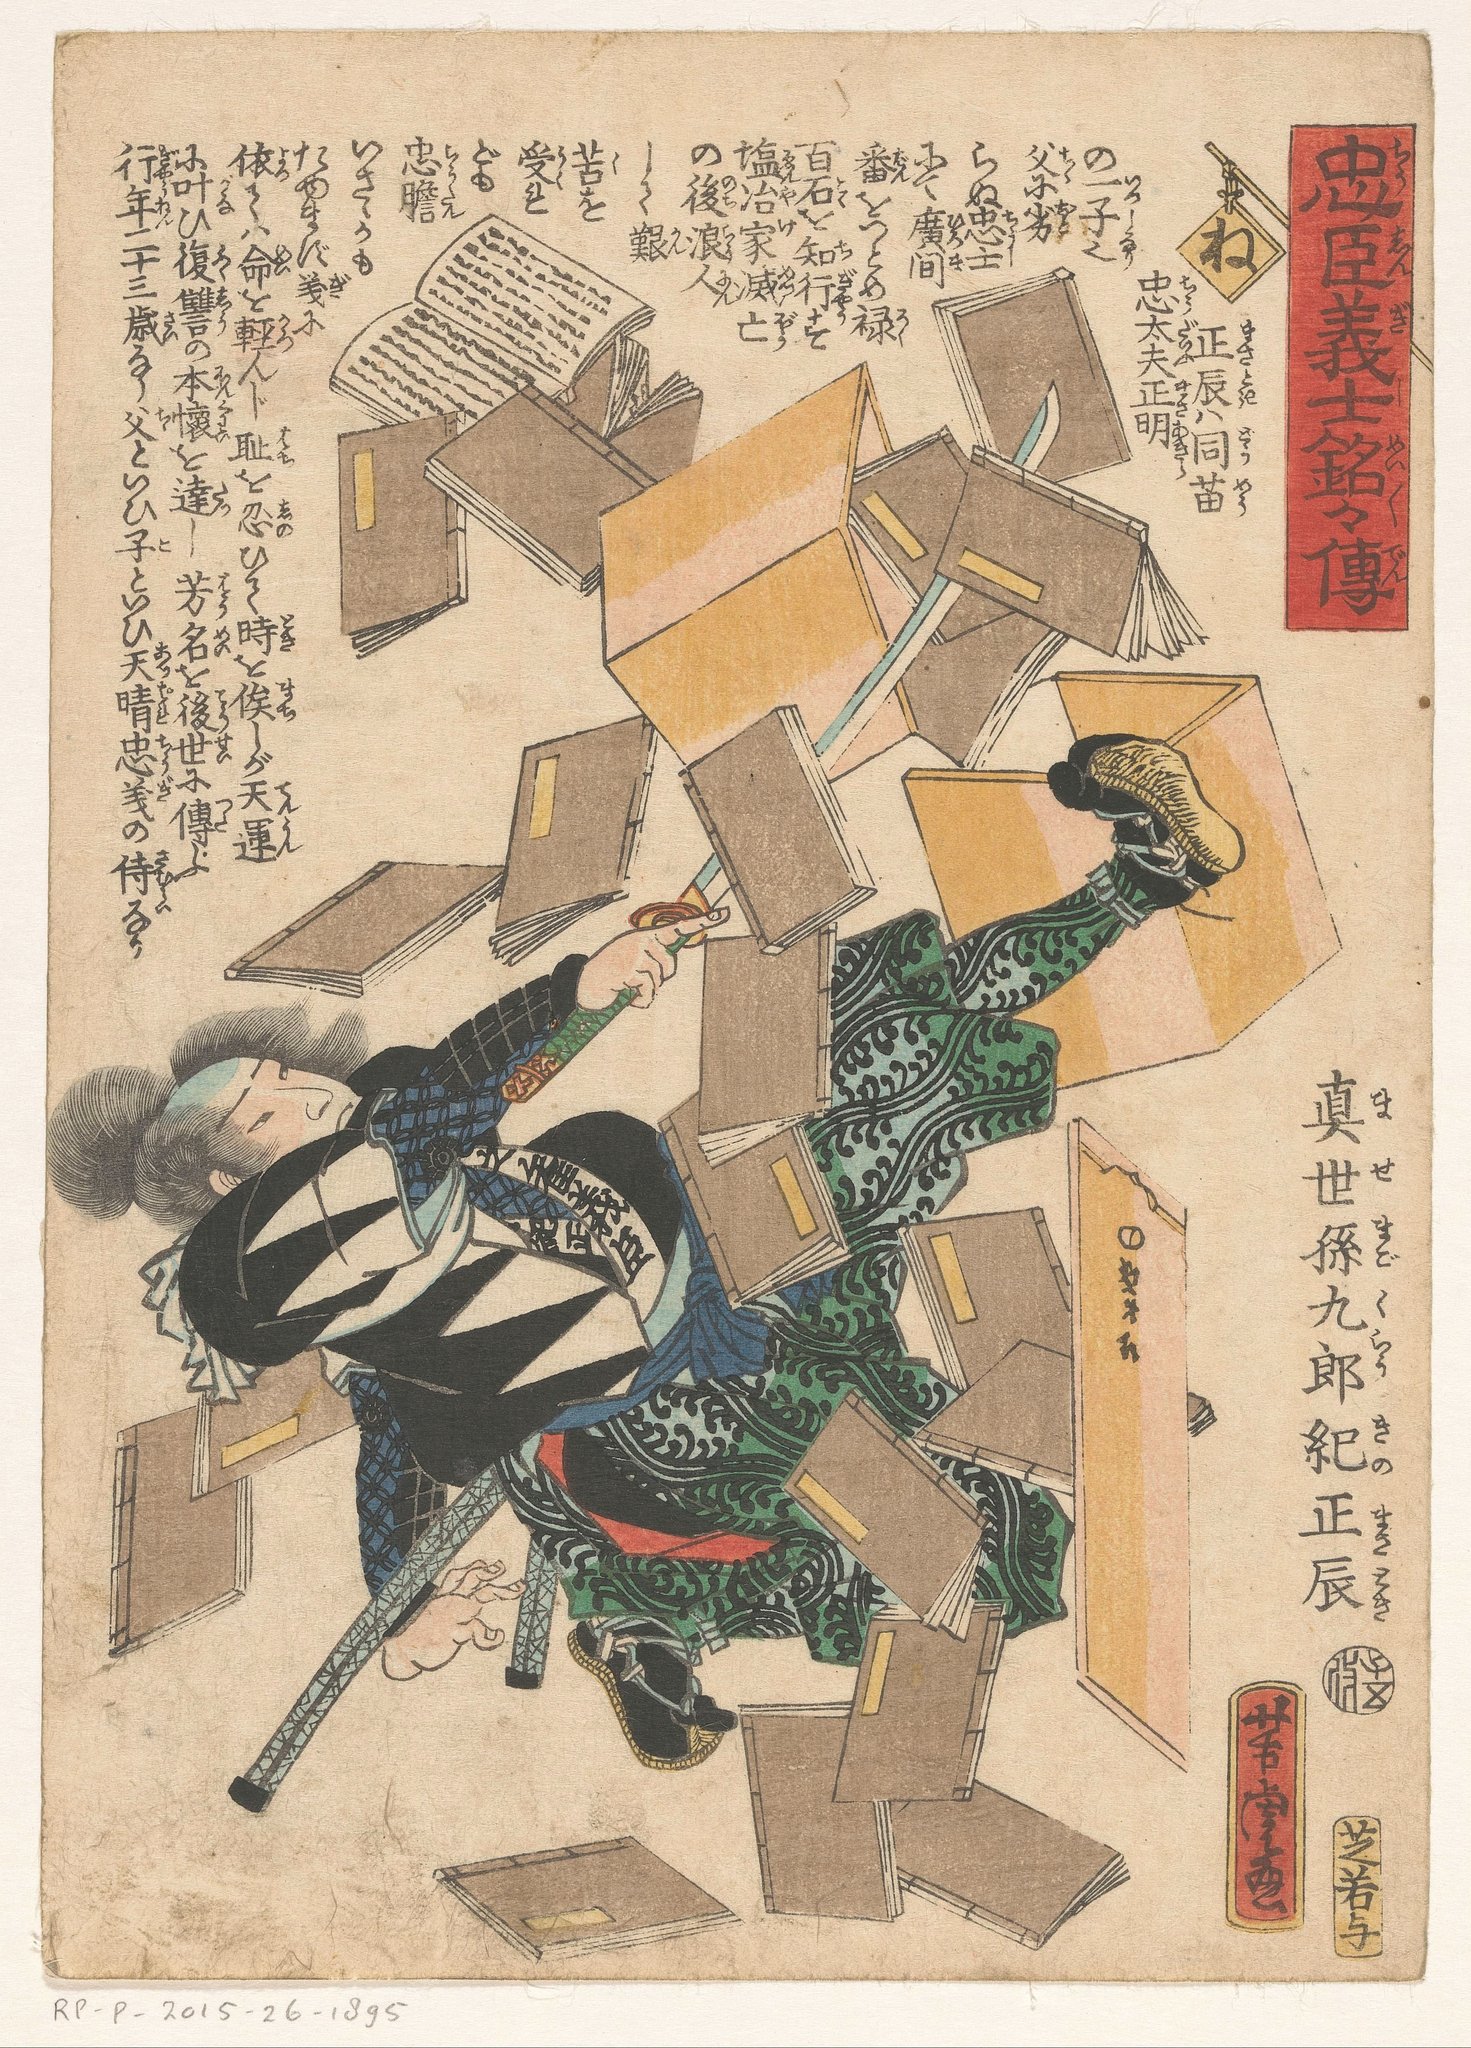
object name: print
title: Vallende boeken op een man met zwaard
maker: utagawa yoshitora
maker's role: print maker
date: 1850-1880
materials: paper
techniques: woodcut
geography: japan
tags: hacking and thrusting weapons: sword, book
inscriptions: collector's mark: Lugt 4780